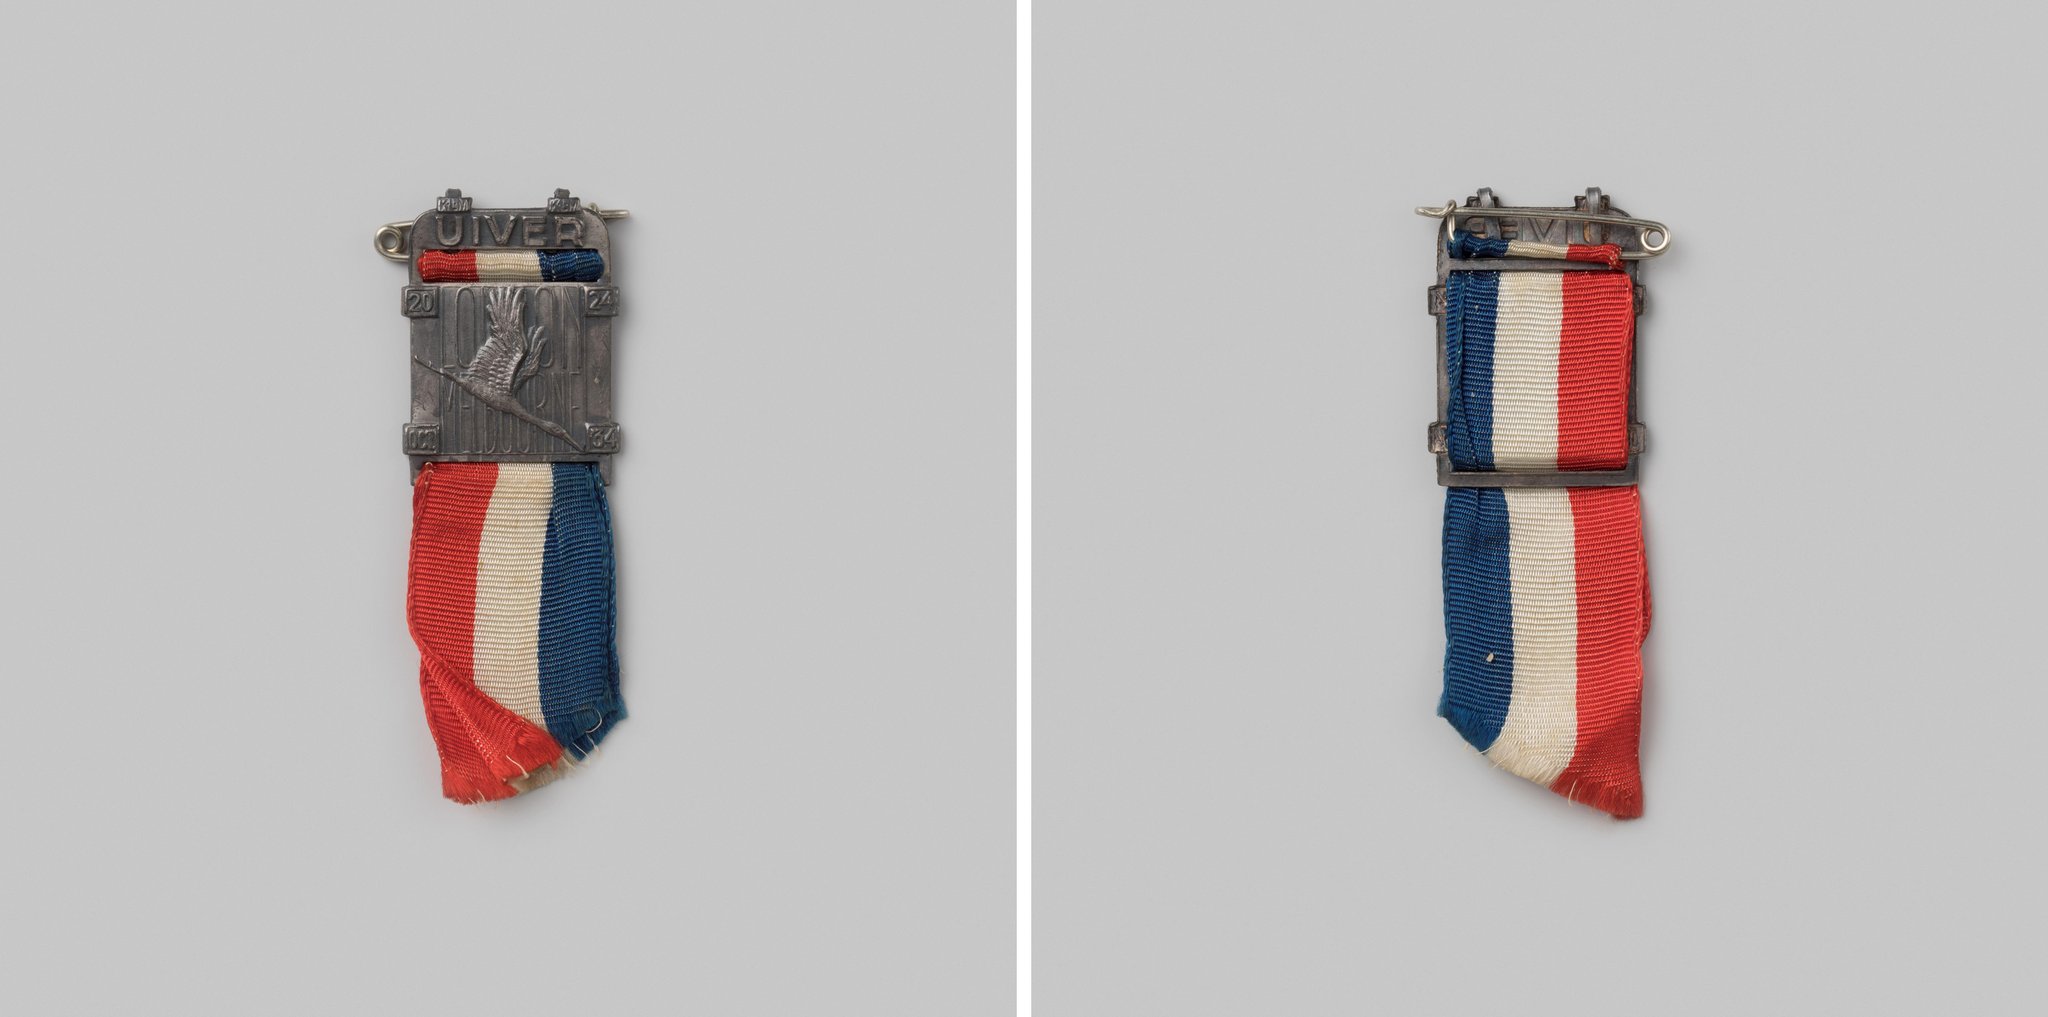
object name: insignia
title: Vlucht van de Uiver van Londen naar Melbourne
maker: Anonymous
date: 1934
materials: silver, textile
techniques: sewing, striking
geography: netherlands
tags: london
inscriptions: date: ‘20, 24, OCT. '34’, inscription: ‘UIVER / KLM’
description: Zilveren eenzijdige, rechthoekige plaquette met afgeronde hoeken; aan bovenzijde twee en aan onderzijde een langwerpige opening, vrijwel over gehele breedte van plaquette, waardoor rood-wit-blauw lint is gestoken waardoor speld. Voorzijde: vliegende ooievaar voor opschrift onder opschrift. Keerzijde: blanco.